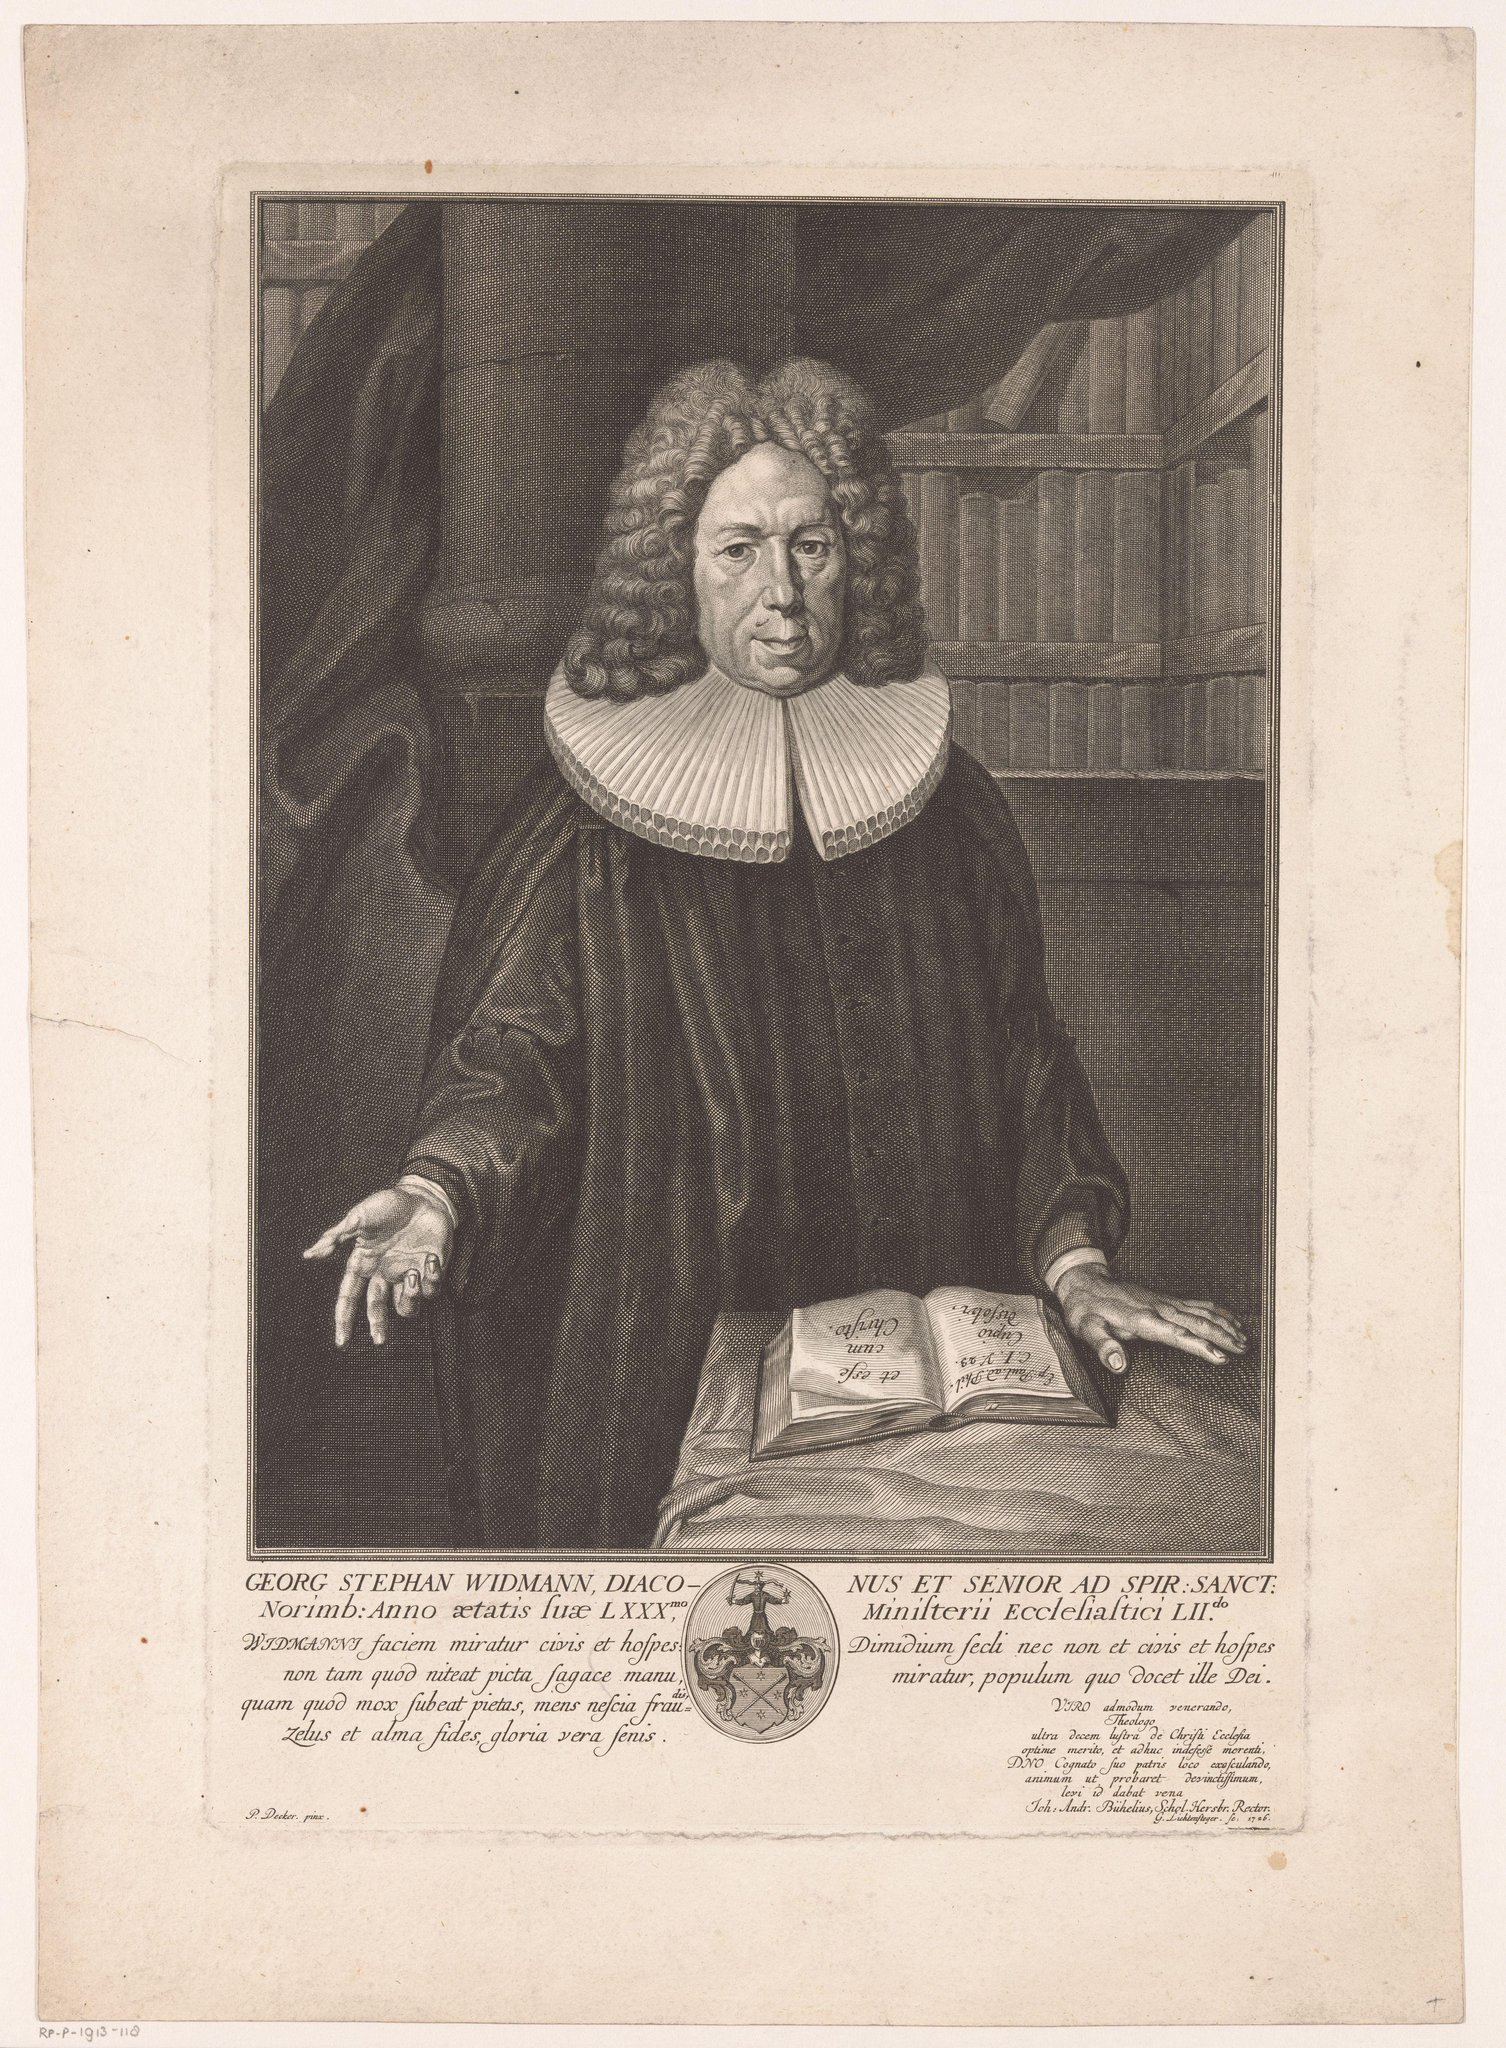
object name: print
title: Portret van Georg Stephan Widmann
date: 1726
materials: paper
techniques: engraving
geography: nuremberg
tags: historical persons, book, armorial bearing, heraldry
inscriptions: collector's mark: Lugt 2228